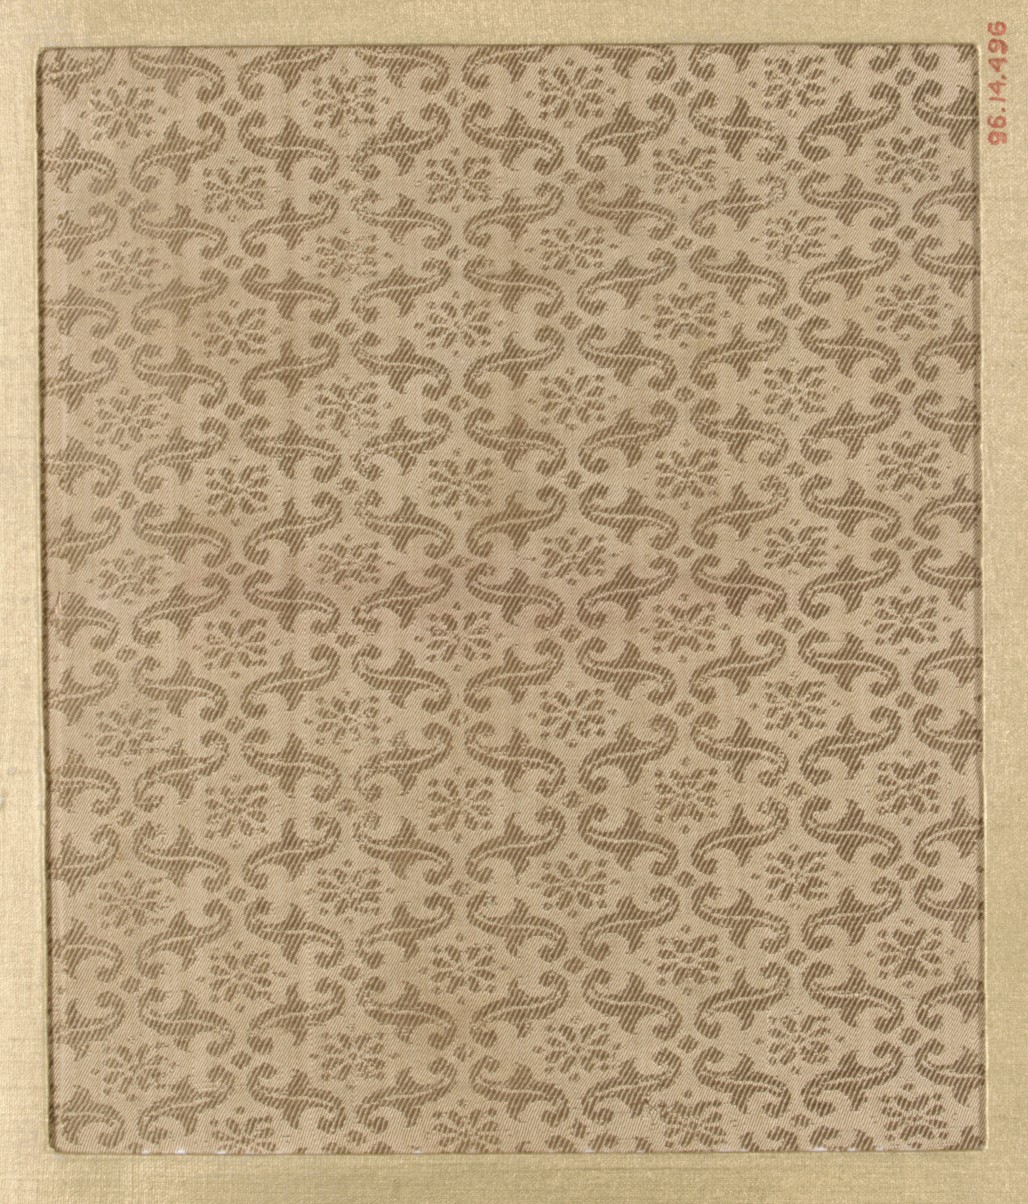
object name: piece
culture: japanese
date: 1701-1900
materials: silk